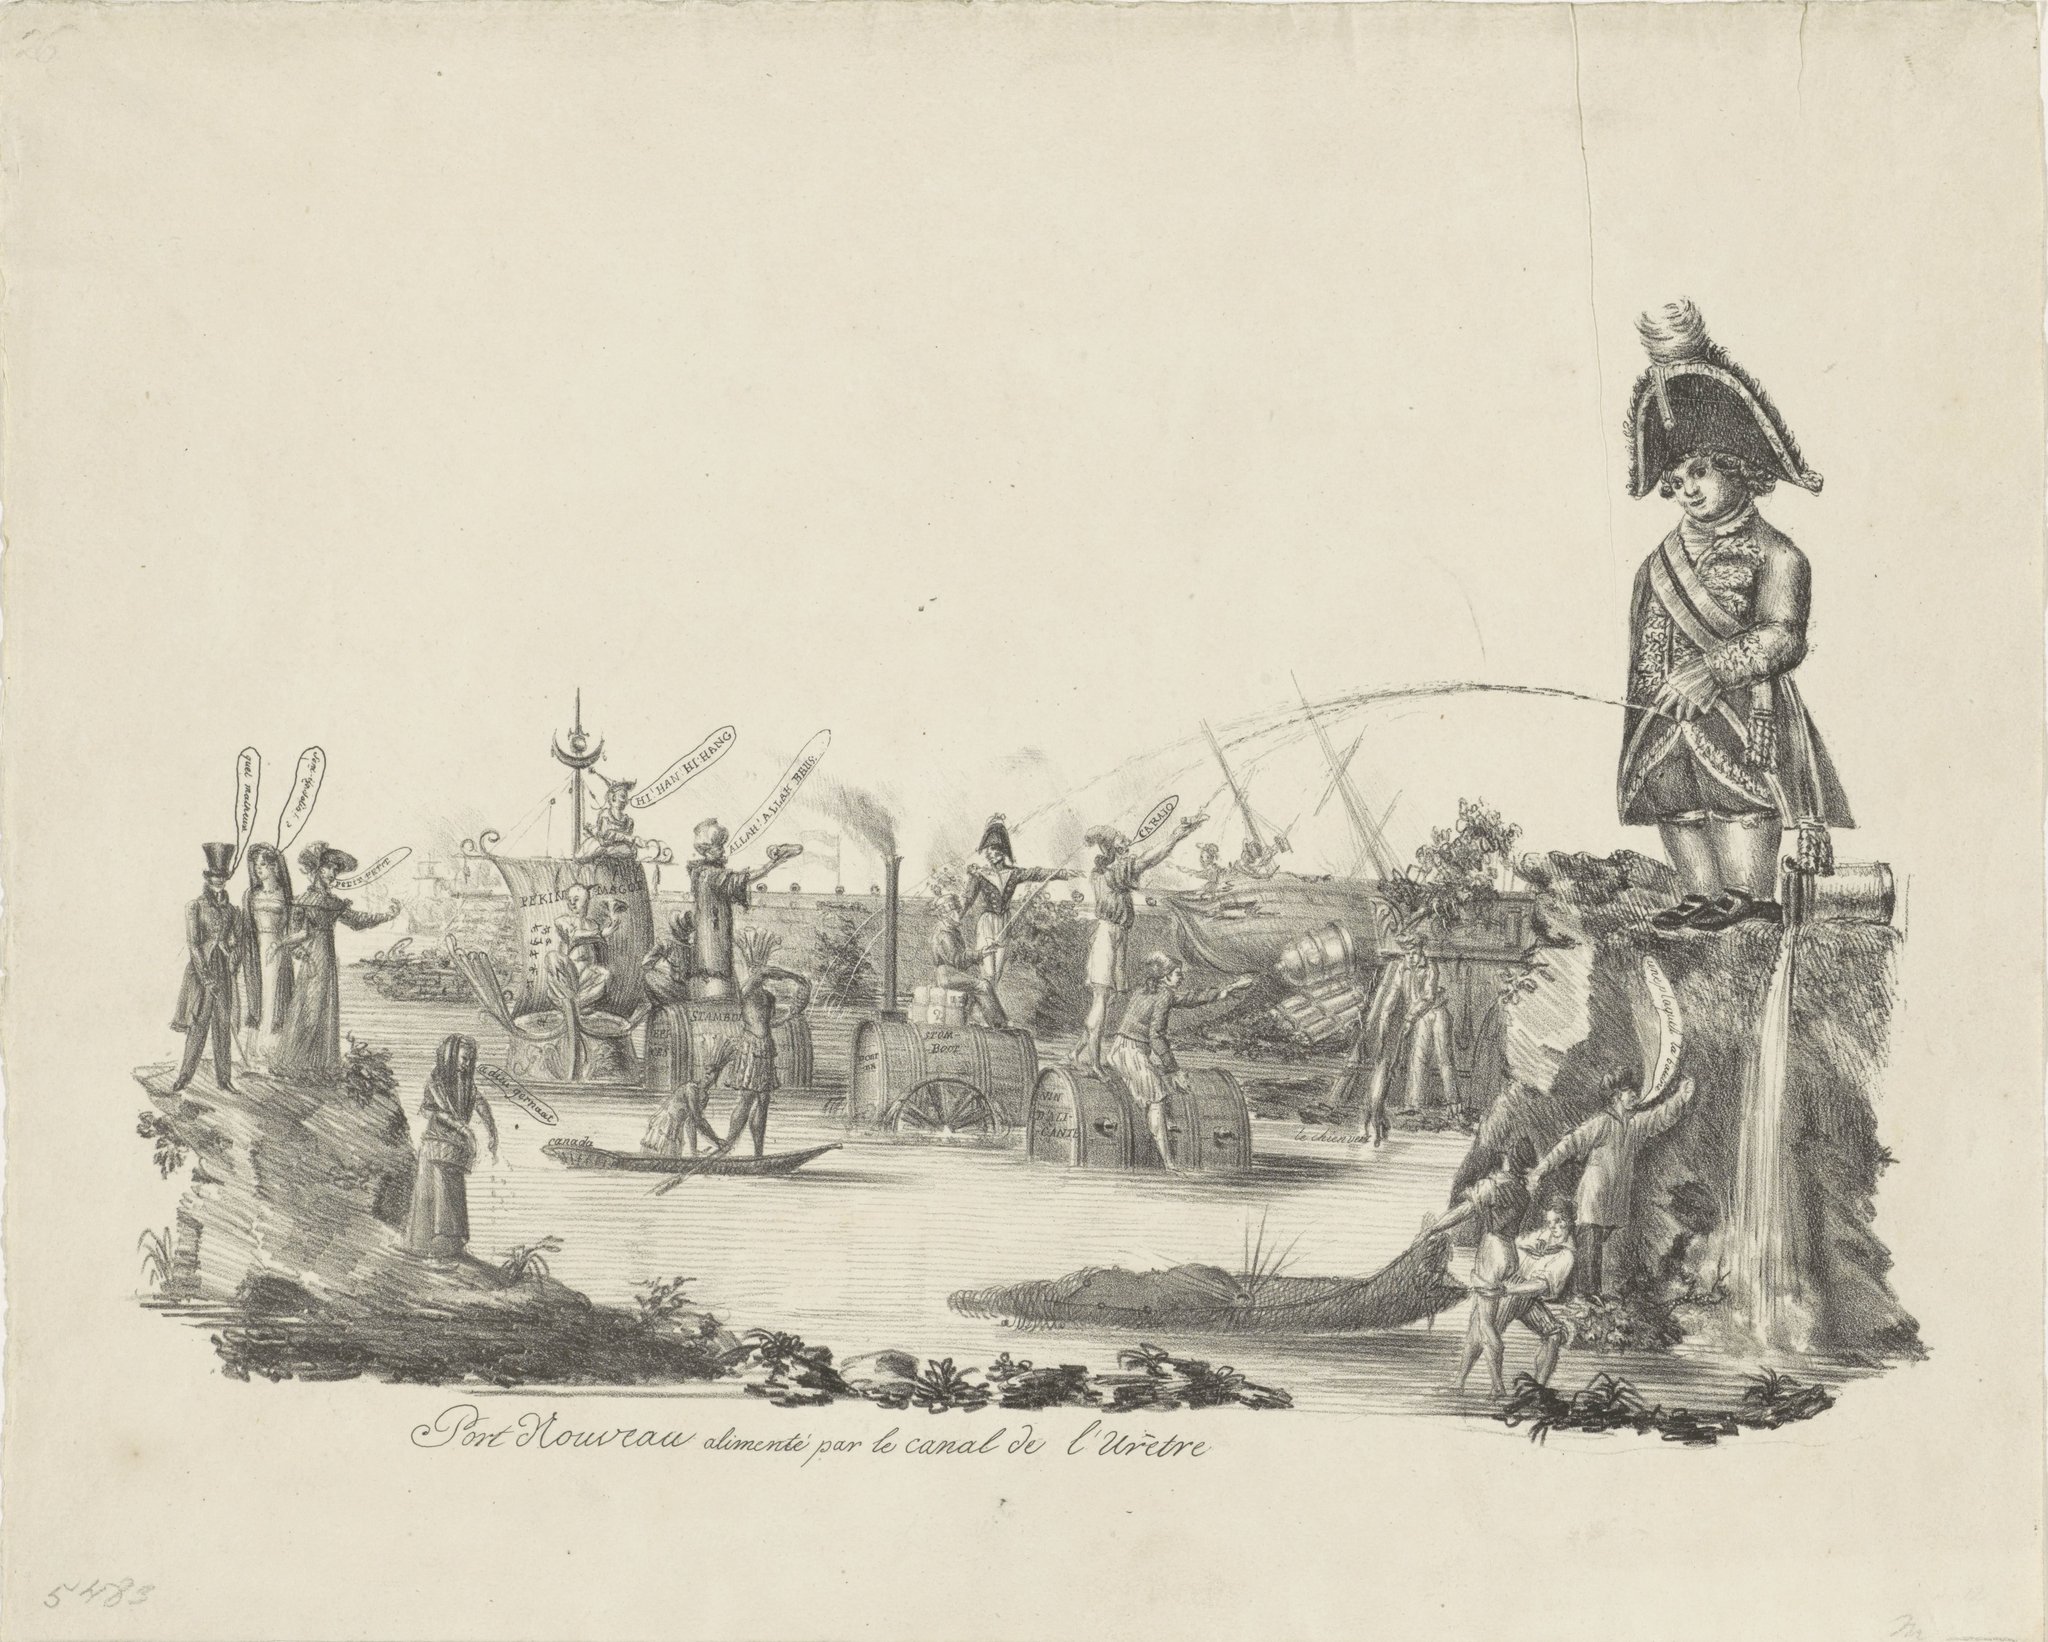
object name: cartoon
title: Port Nouveau alimenté par le canal de l'Urêtre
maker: Anonymous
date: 1828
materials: paper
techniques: lithograph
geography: southern netherlands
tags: europeans: spaniards, asiatic races and peoples: turks, chinese, canal, indigenous peoples of north america, native peoples of the americas, urination, traffic on the water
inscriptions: collector's mark: Lugt 2228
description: Spotprent op het nieuwe kanaal van Charleroi naar Brussel, gebouwd tussen 1827-1832. Rechts pist Manneken Pis in het kanaal, links varen mensen uit onder andere Canada, Peking, Amerika, Alicante en het Ottomaanse Rijks op vaten en vaartuigen door het kanaal. Met schalen of kommen proberen ze de pis van Manneke Pis op te vangen. Onderschrift in het Frans.